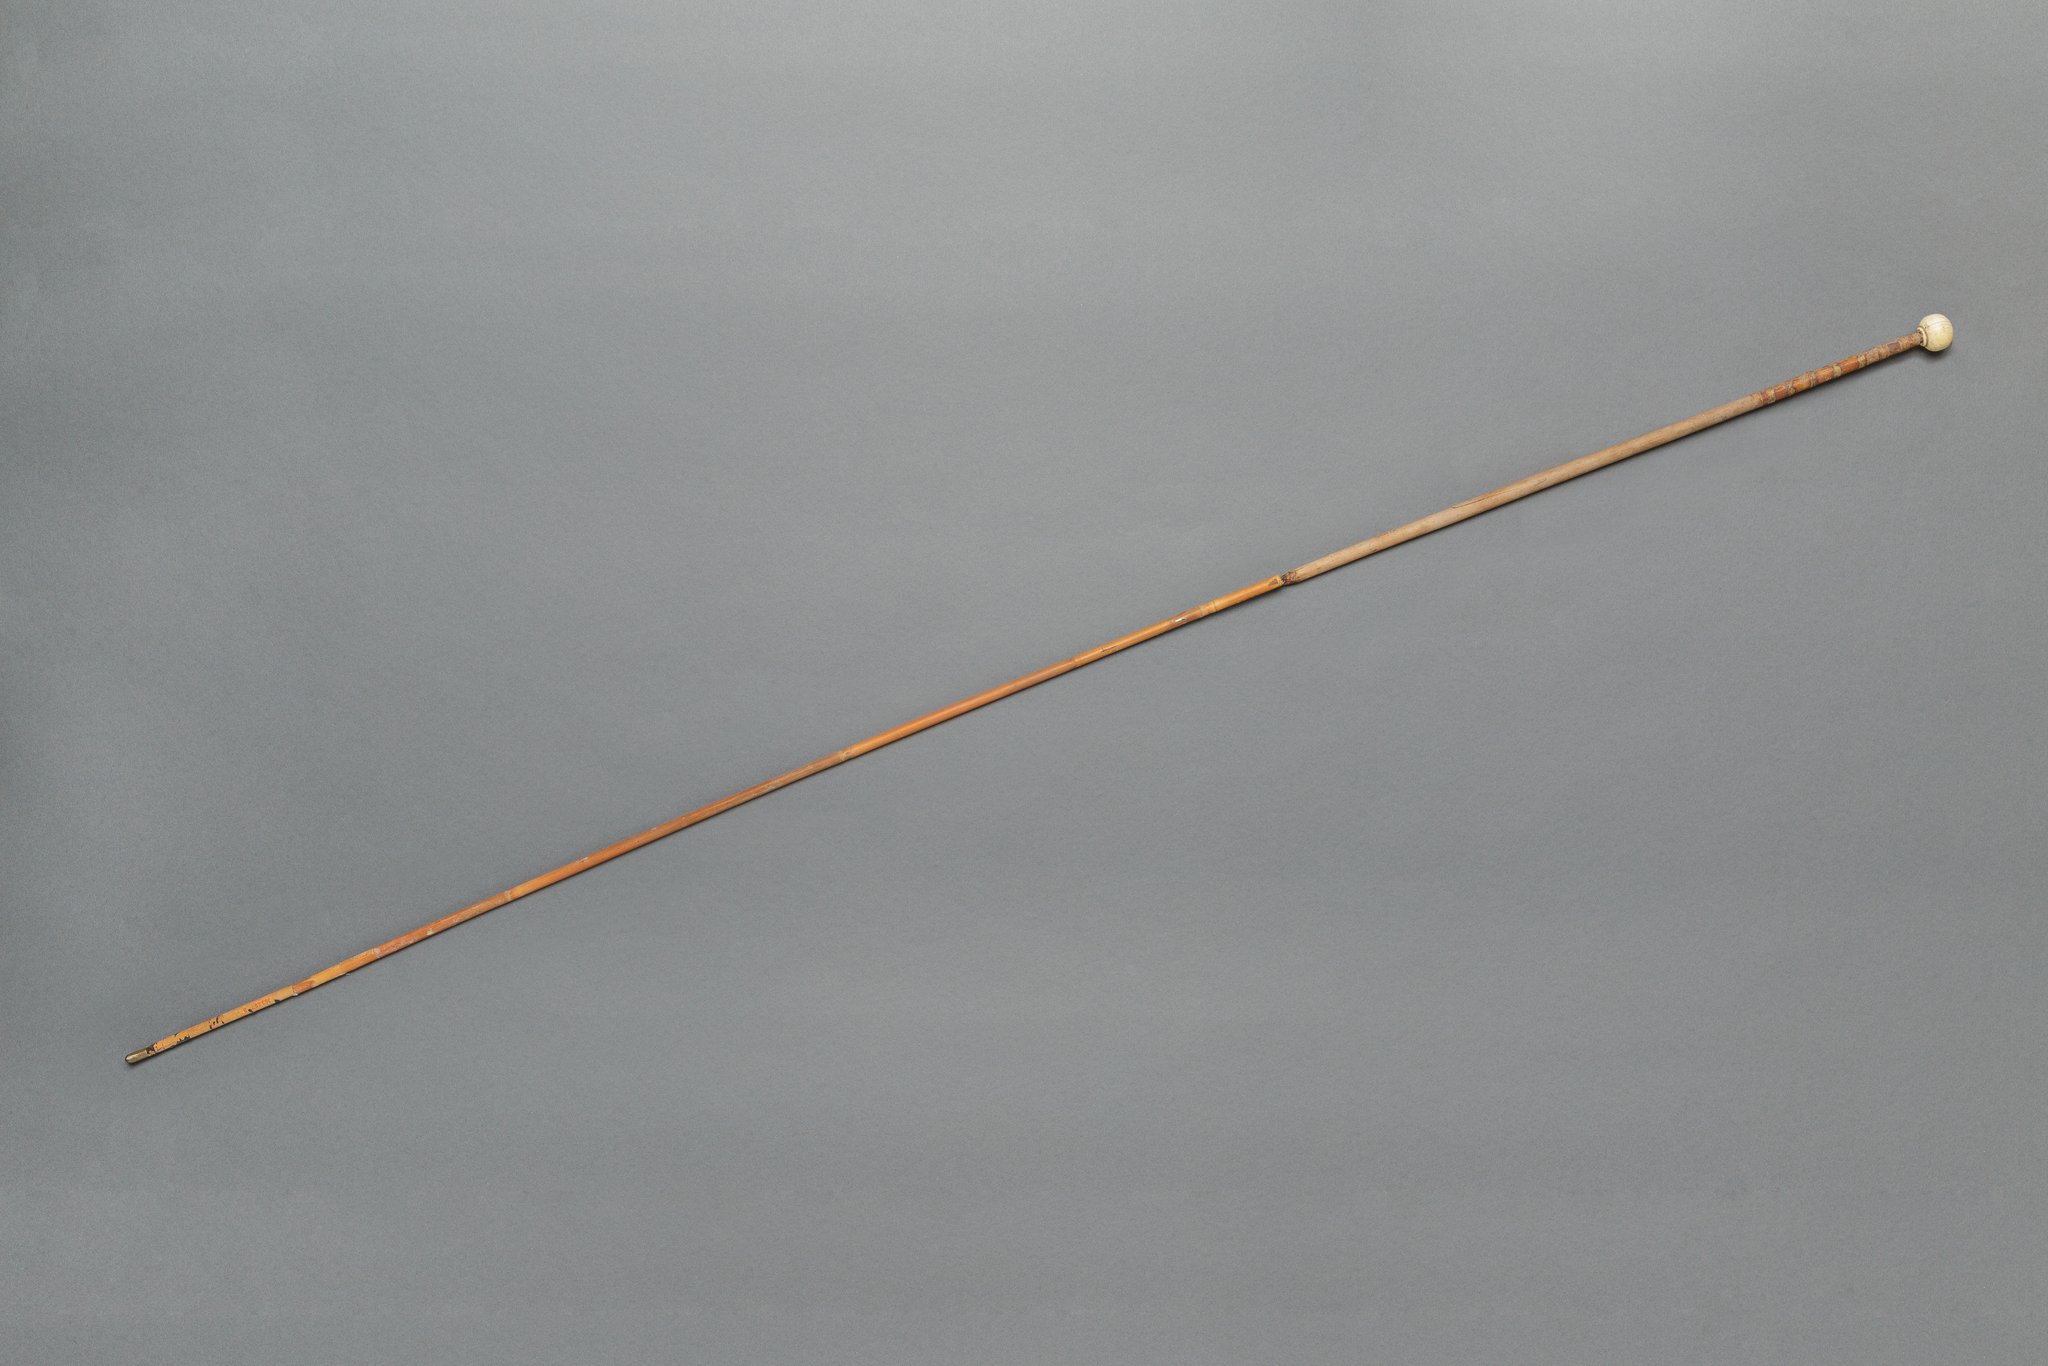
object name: spear, hilt, shaft, blunt pile, knob, bark decoration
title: Javelin with an Ivory Knob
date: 1479-1458 BCE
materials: ivory, wood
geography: egypt